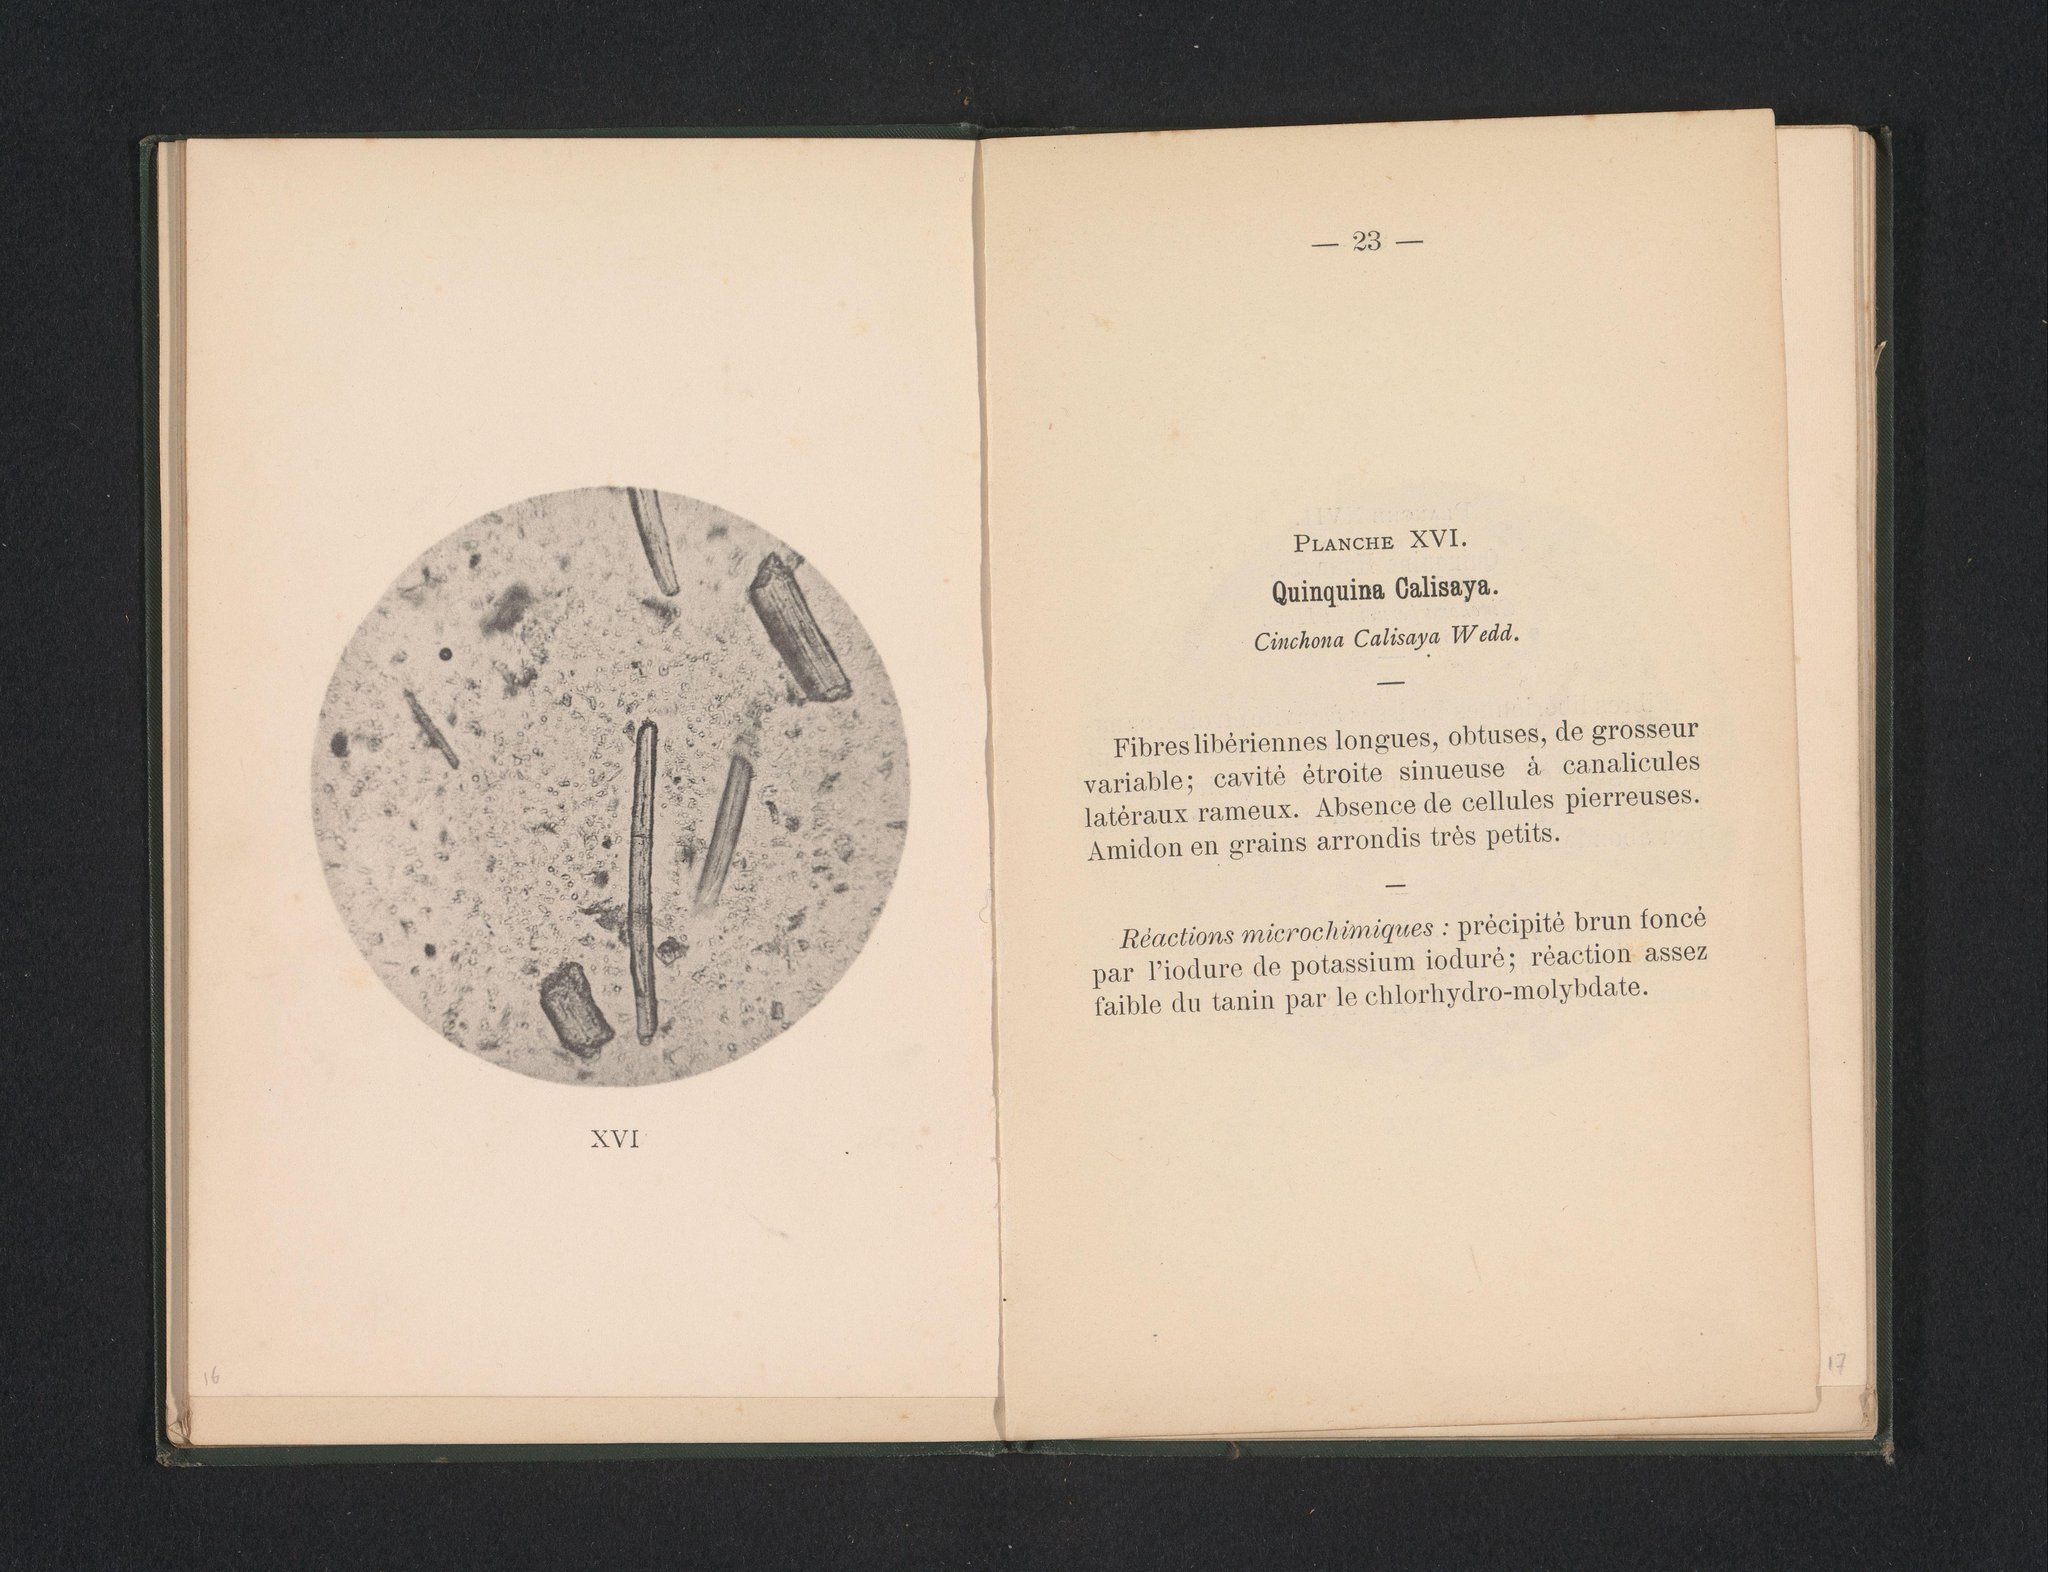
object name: page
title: Microscopische weergave van gele kina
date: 1891-1896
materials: paper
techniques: photograph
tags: microscope (+ scientific research)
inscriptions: number: ‘XVI’